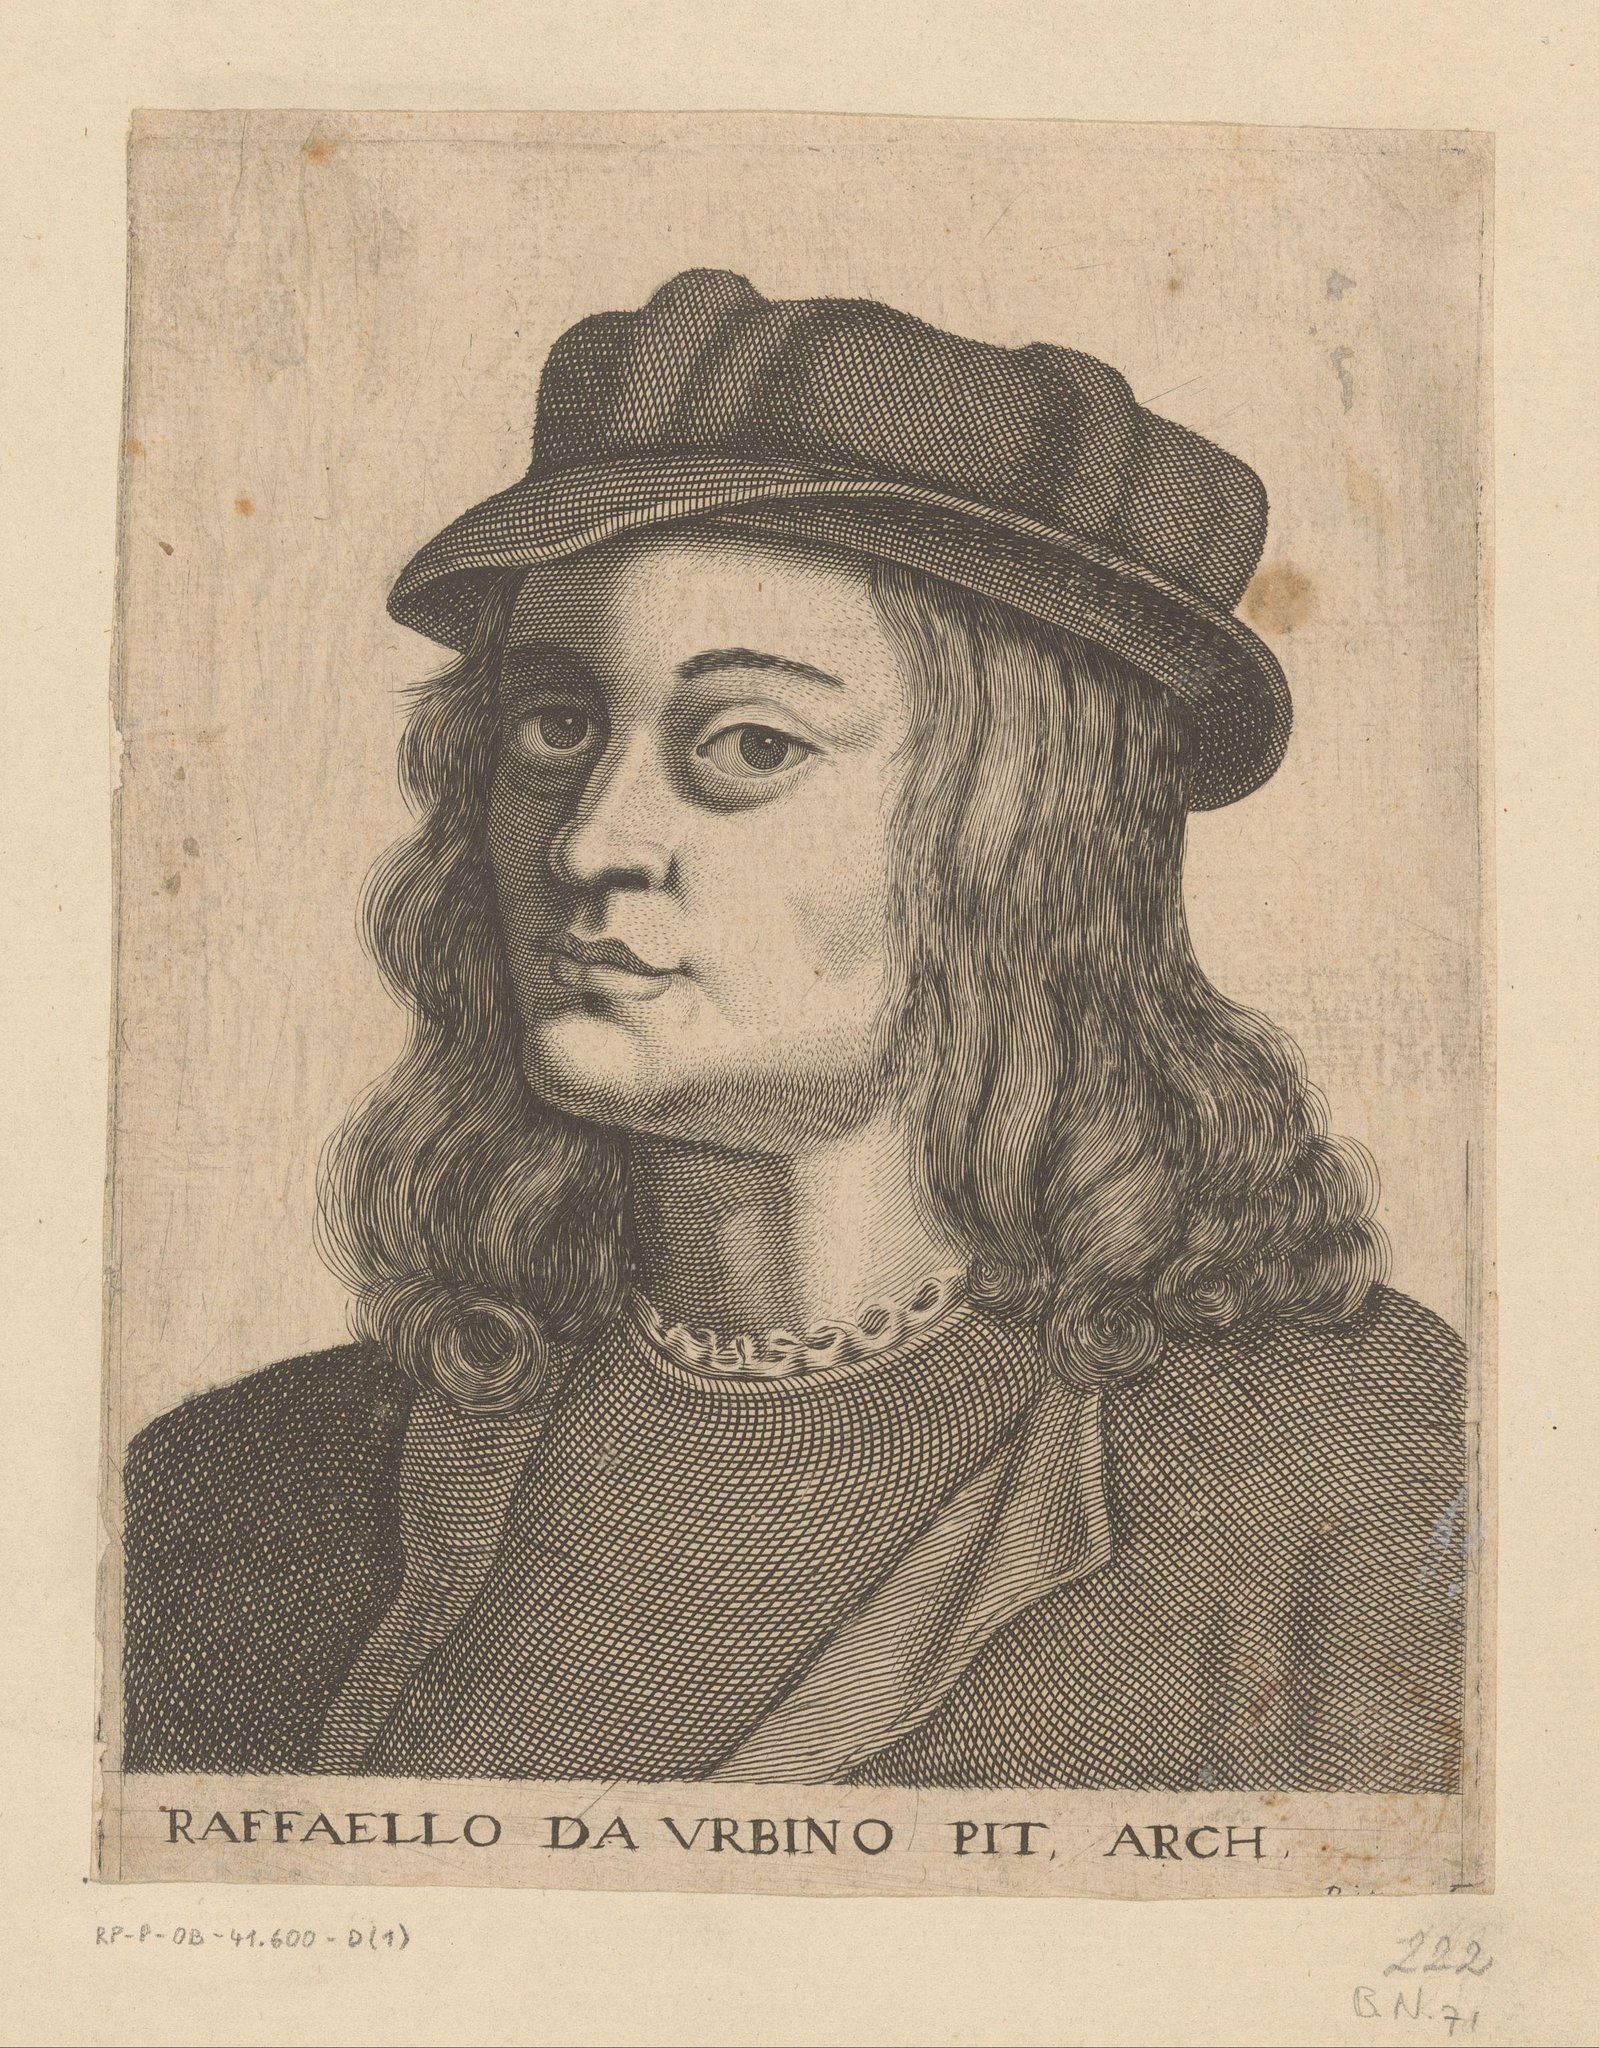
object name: print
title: Raffaello da Urbino pit arch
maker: jean baron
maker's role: print maker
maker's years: 1616-1655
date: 1641-1741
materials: paper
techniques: engraving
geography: france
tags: rome, painter, rafaël, portrait, self-portrait of painter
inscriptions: collector's mark: Lugt 240